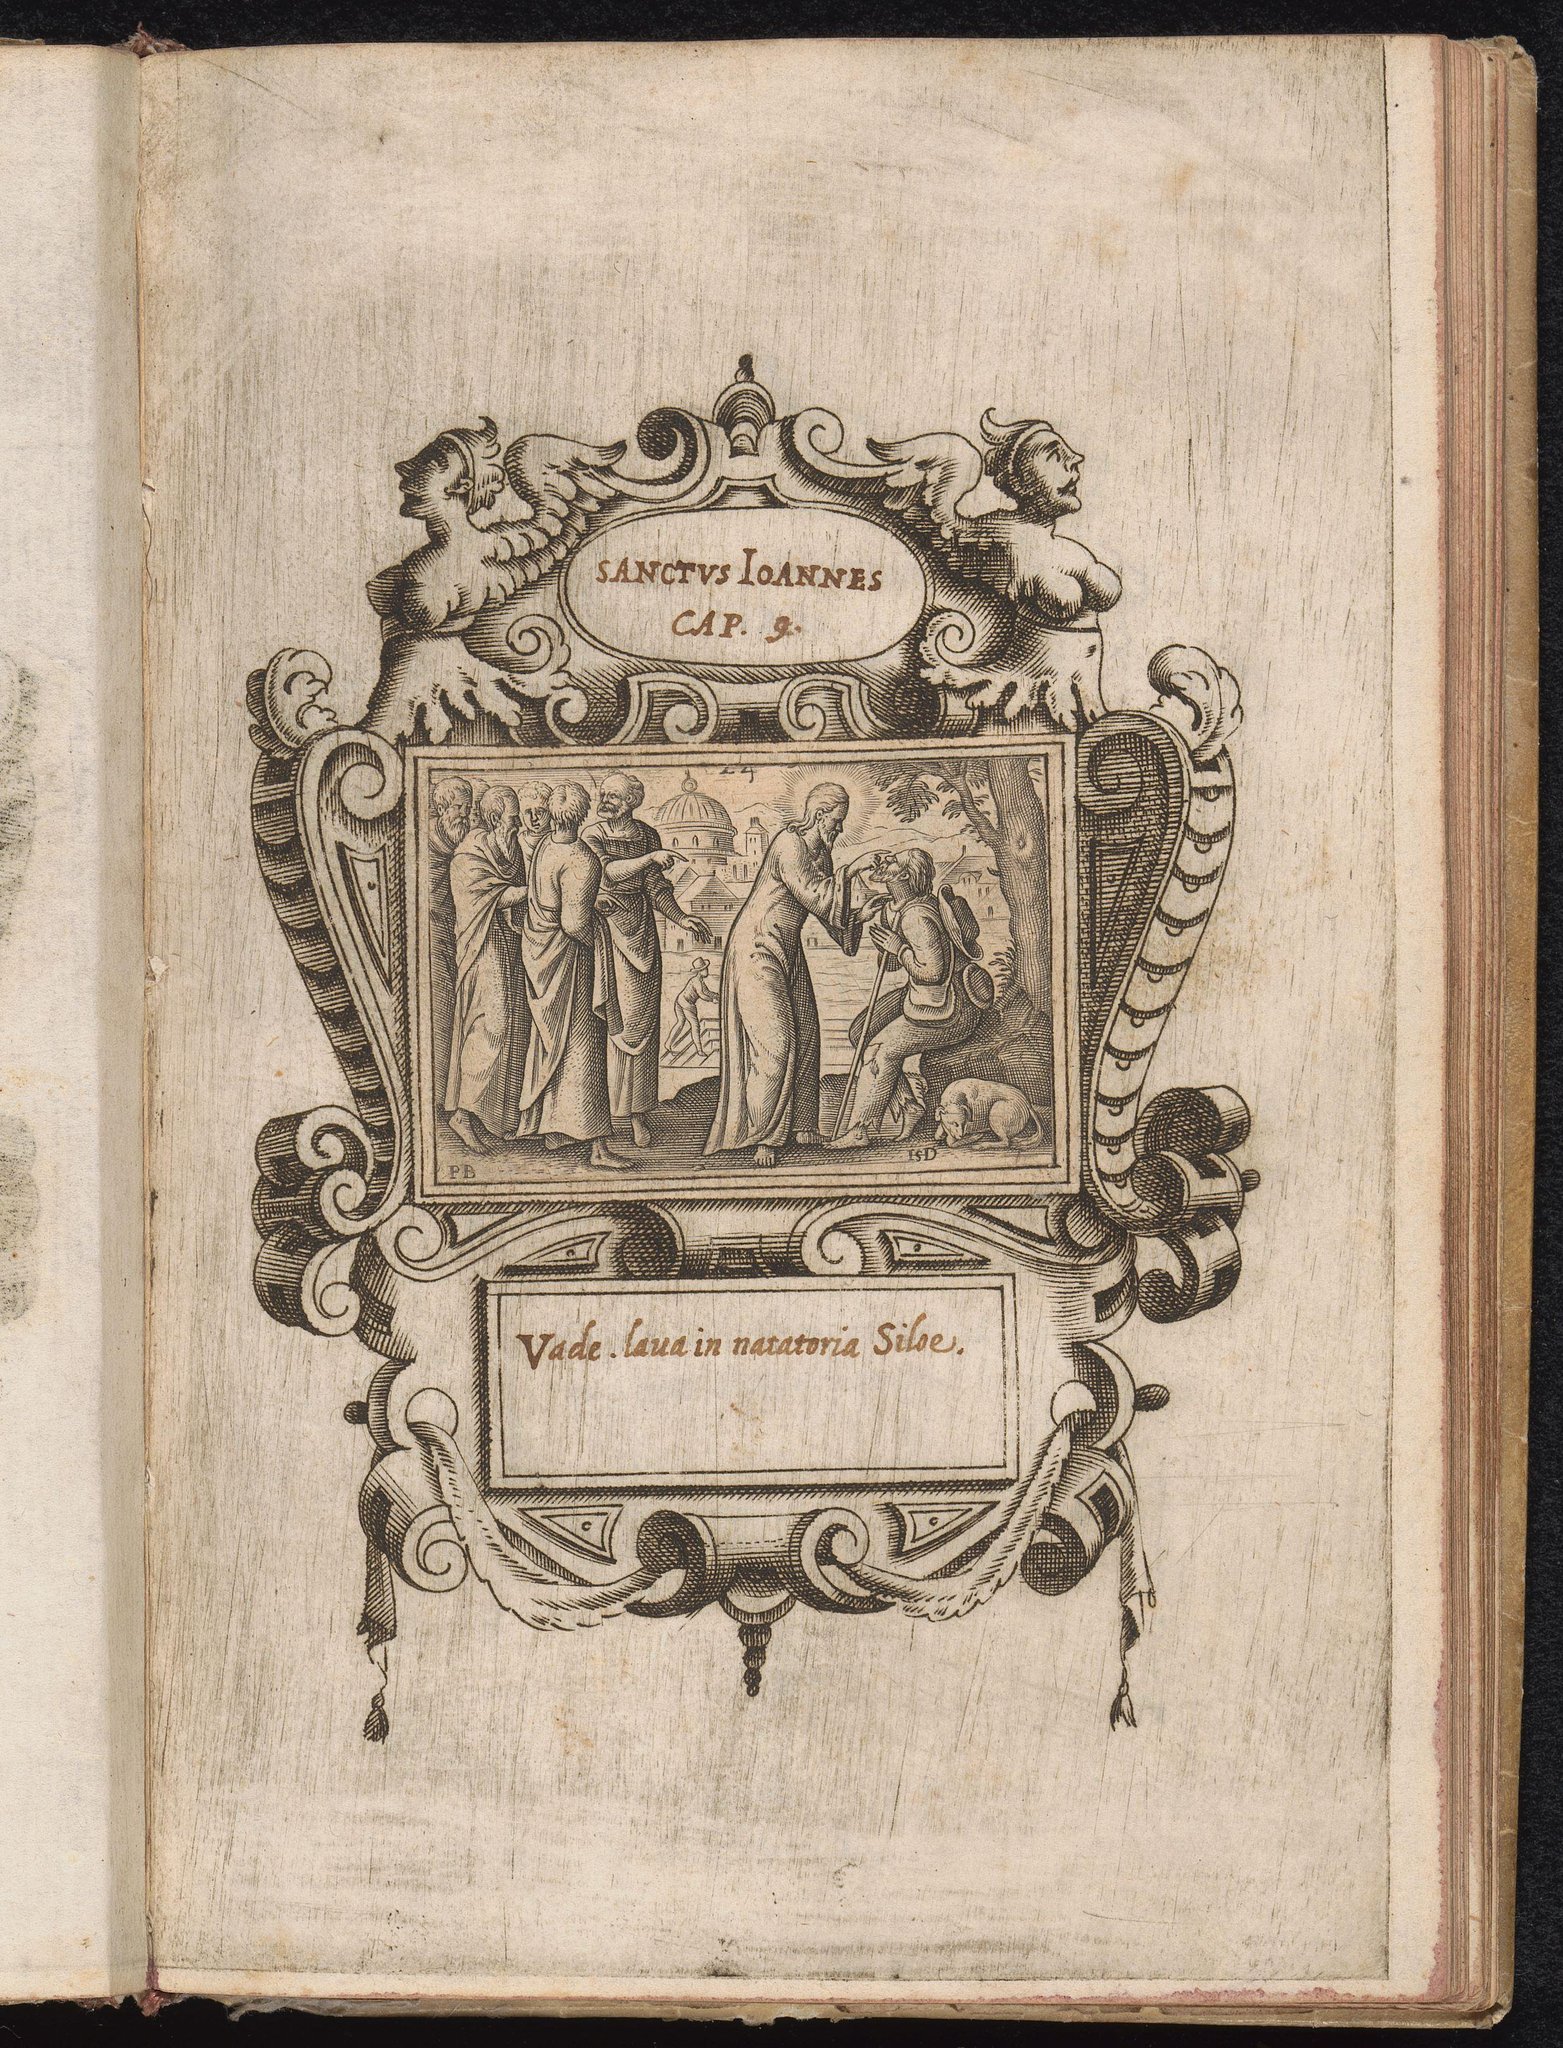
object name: print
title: Christus geneest een blinde man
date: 1570-1610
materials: paper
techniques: engraving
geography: antwerp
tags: healing of a man born blind: christ touches his eyes with an 'ointment' of dust and spittle (john 9)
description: Christus geneest een blinde man. Onderdeel van een prentalbum met titelprent en 56 scènes uit het Nieuwe Testament. Elke voorstelling gemonteerd in een gravure met ornamentele cartouches waarin een venster is gesneden en voorzien van handgeschreven bijbelpassages.